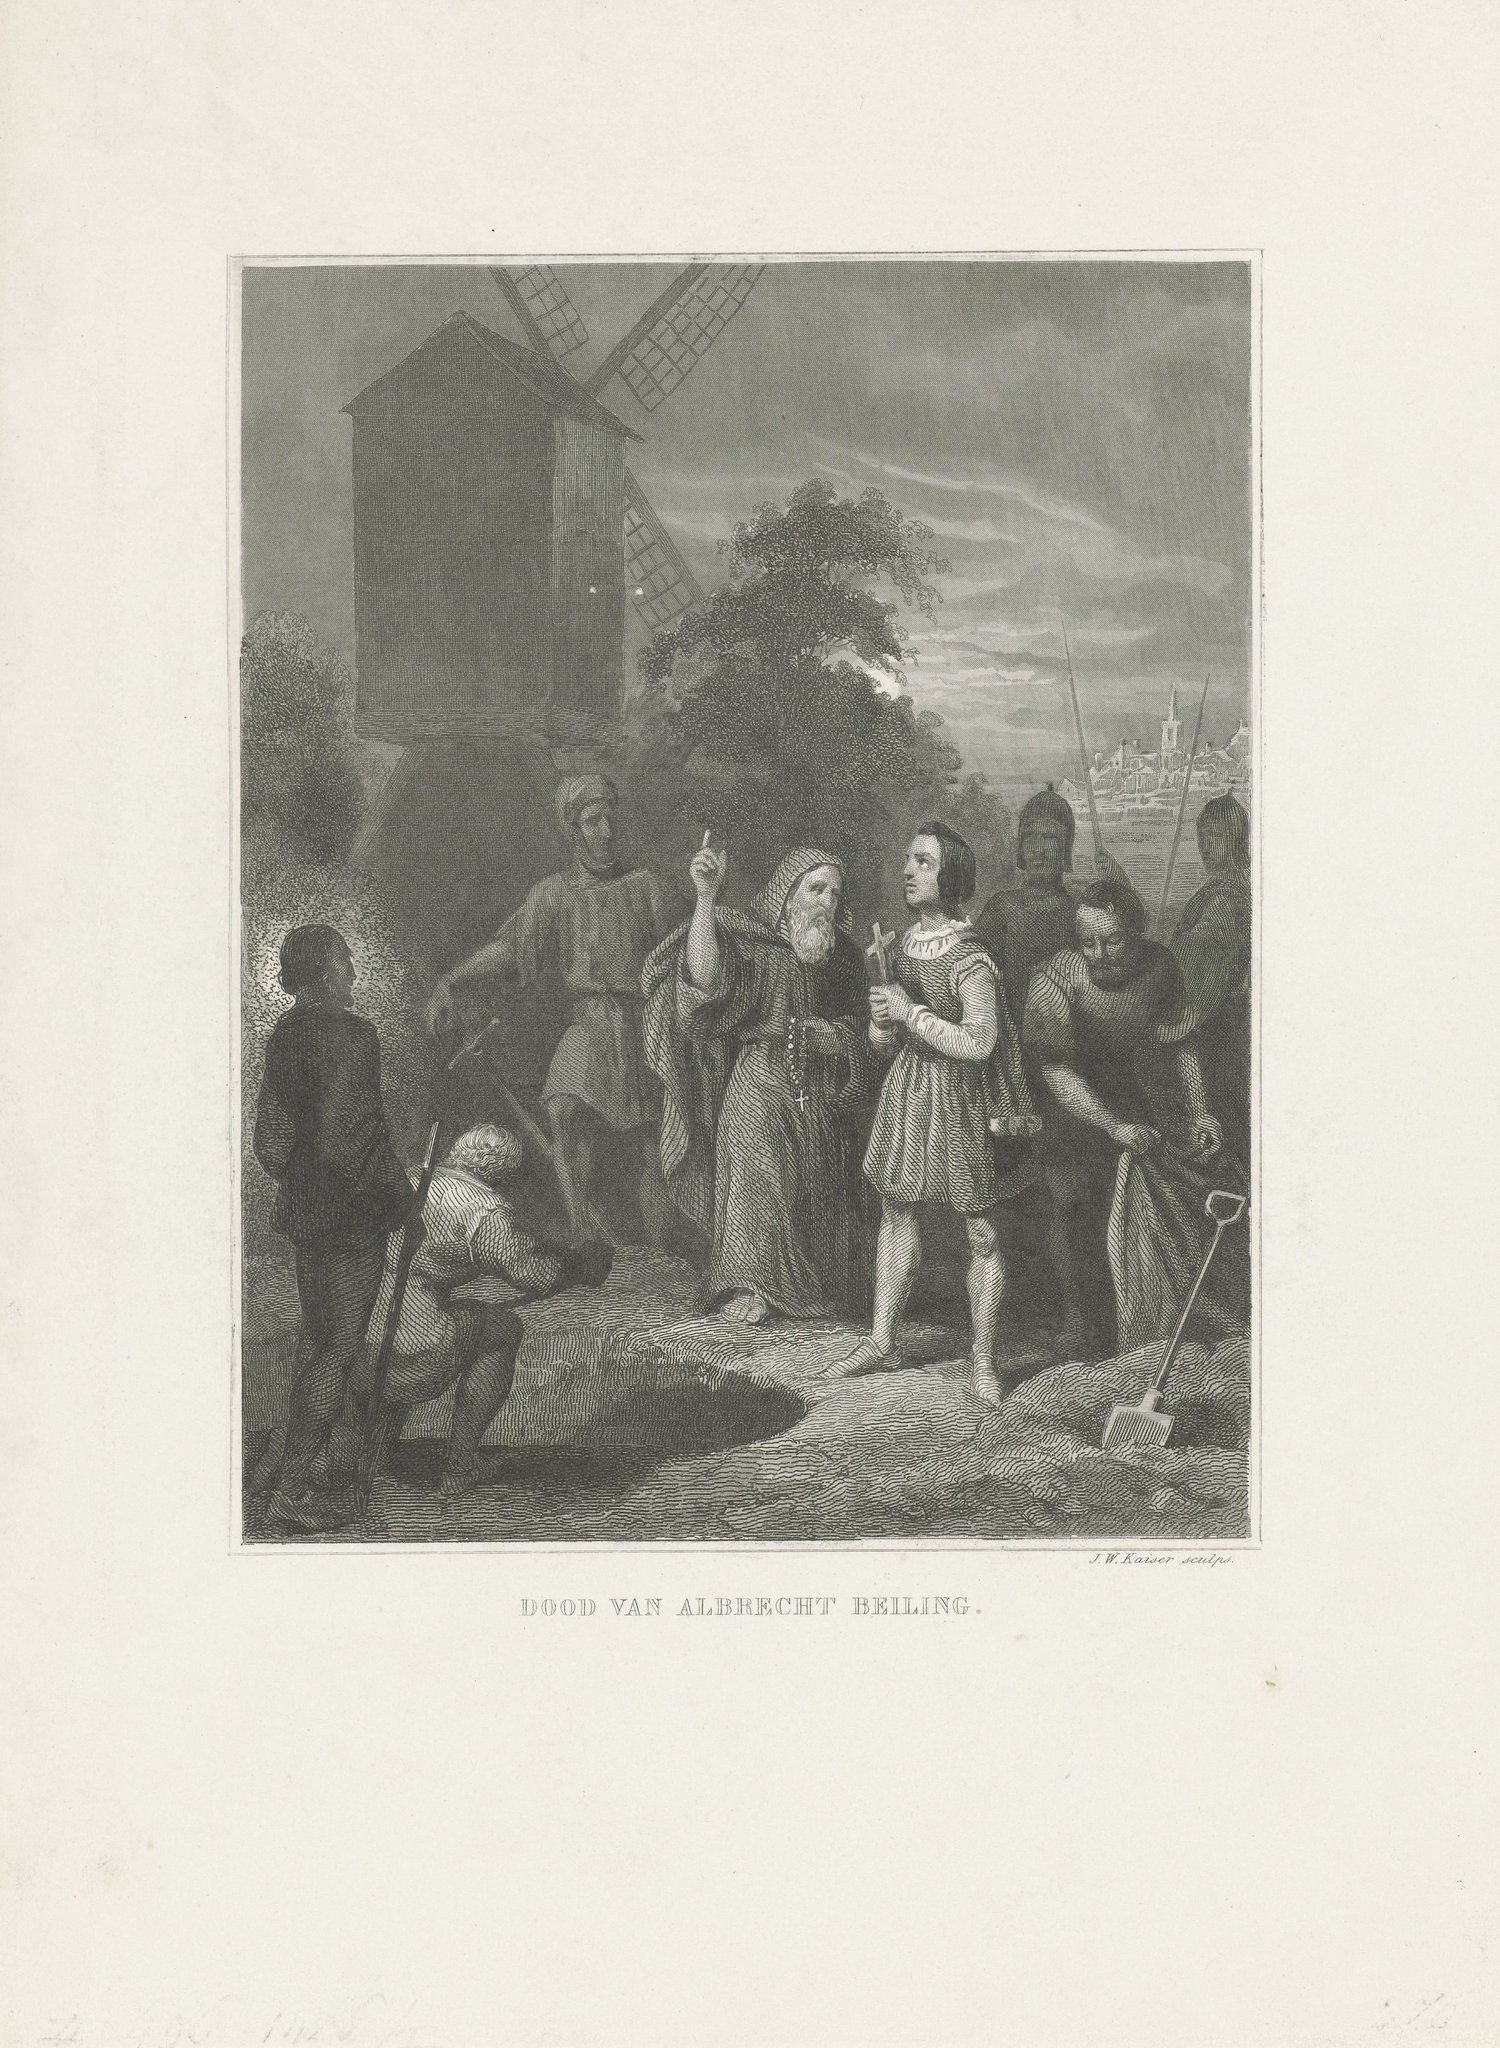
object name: book illustration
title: Dood van Albrecht Beiling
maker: johann wilhelm kaiser (i)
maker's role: draughtsman, print maker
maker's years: 1813-1900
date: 1840-1884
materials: paper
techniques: engraving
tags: jacoba of bavaria (countess of hainaut), windmill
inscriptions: collector's mark: Lugt 2228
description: Albrecht Beiling, bevelhebber in Schoonhoven, werd door Jacoba van Beieren veroordeeld om levend begraven te worden, in het jaar 1426. Albrecht staat met een kruis in zijn handen en zijn gezicht naar de hemel gericht voor zijn eigen graf. De geestelijke naast hem wijst op de hemel en heeft een rozenkrans bij zich.